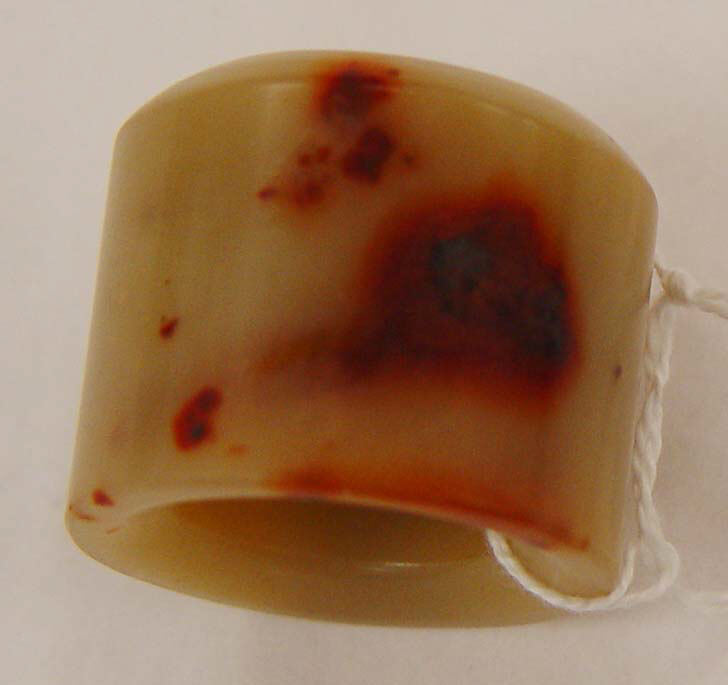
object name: ring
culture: chinese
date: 1801-1900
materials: stone